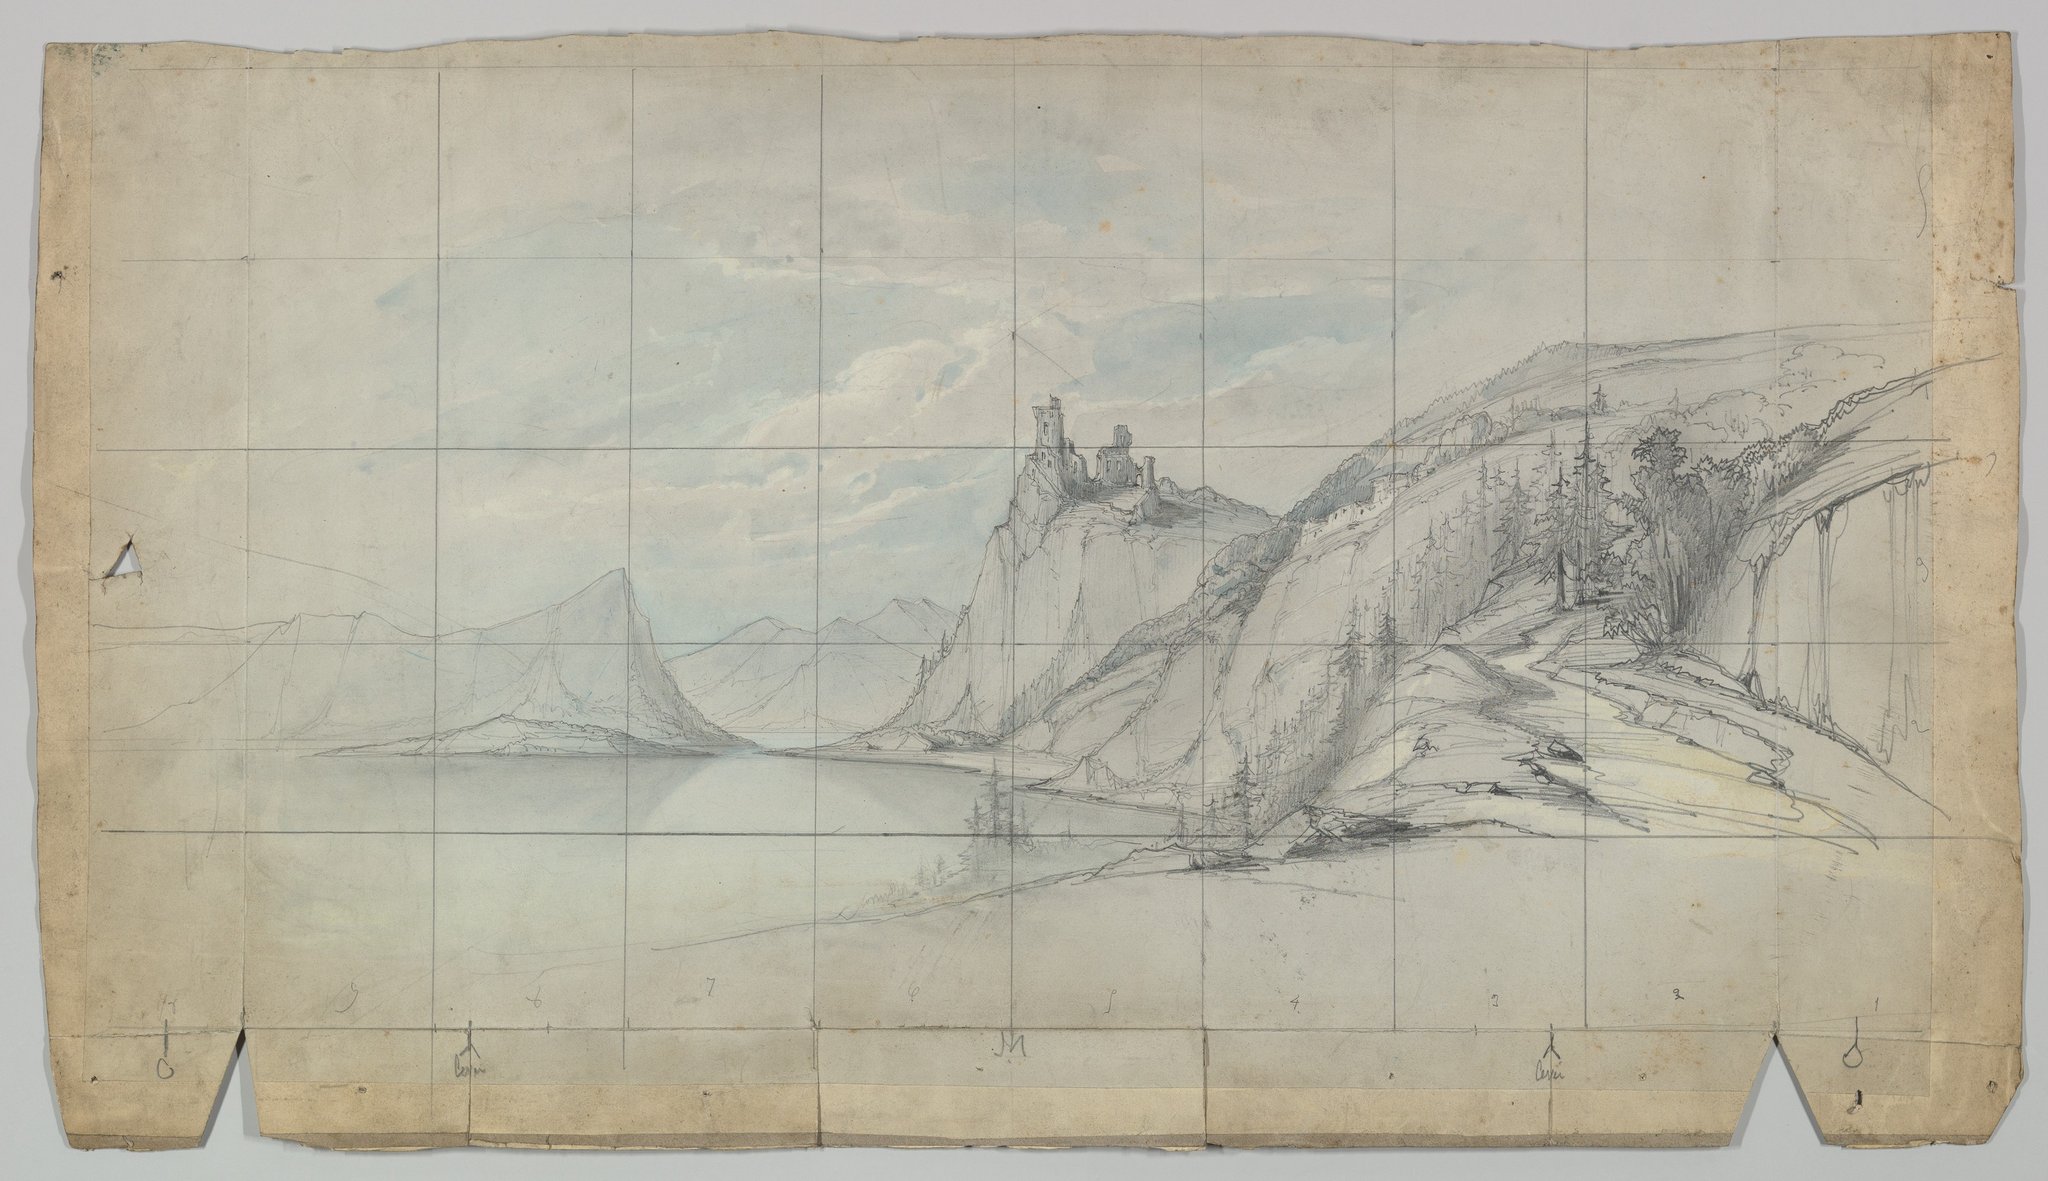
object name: drawing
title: Design for a Stage Set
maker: eugène cicéri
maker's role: artist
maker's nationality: french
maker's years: 1813-1890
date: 1830-1890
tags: landscapes,stage design